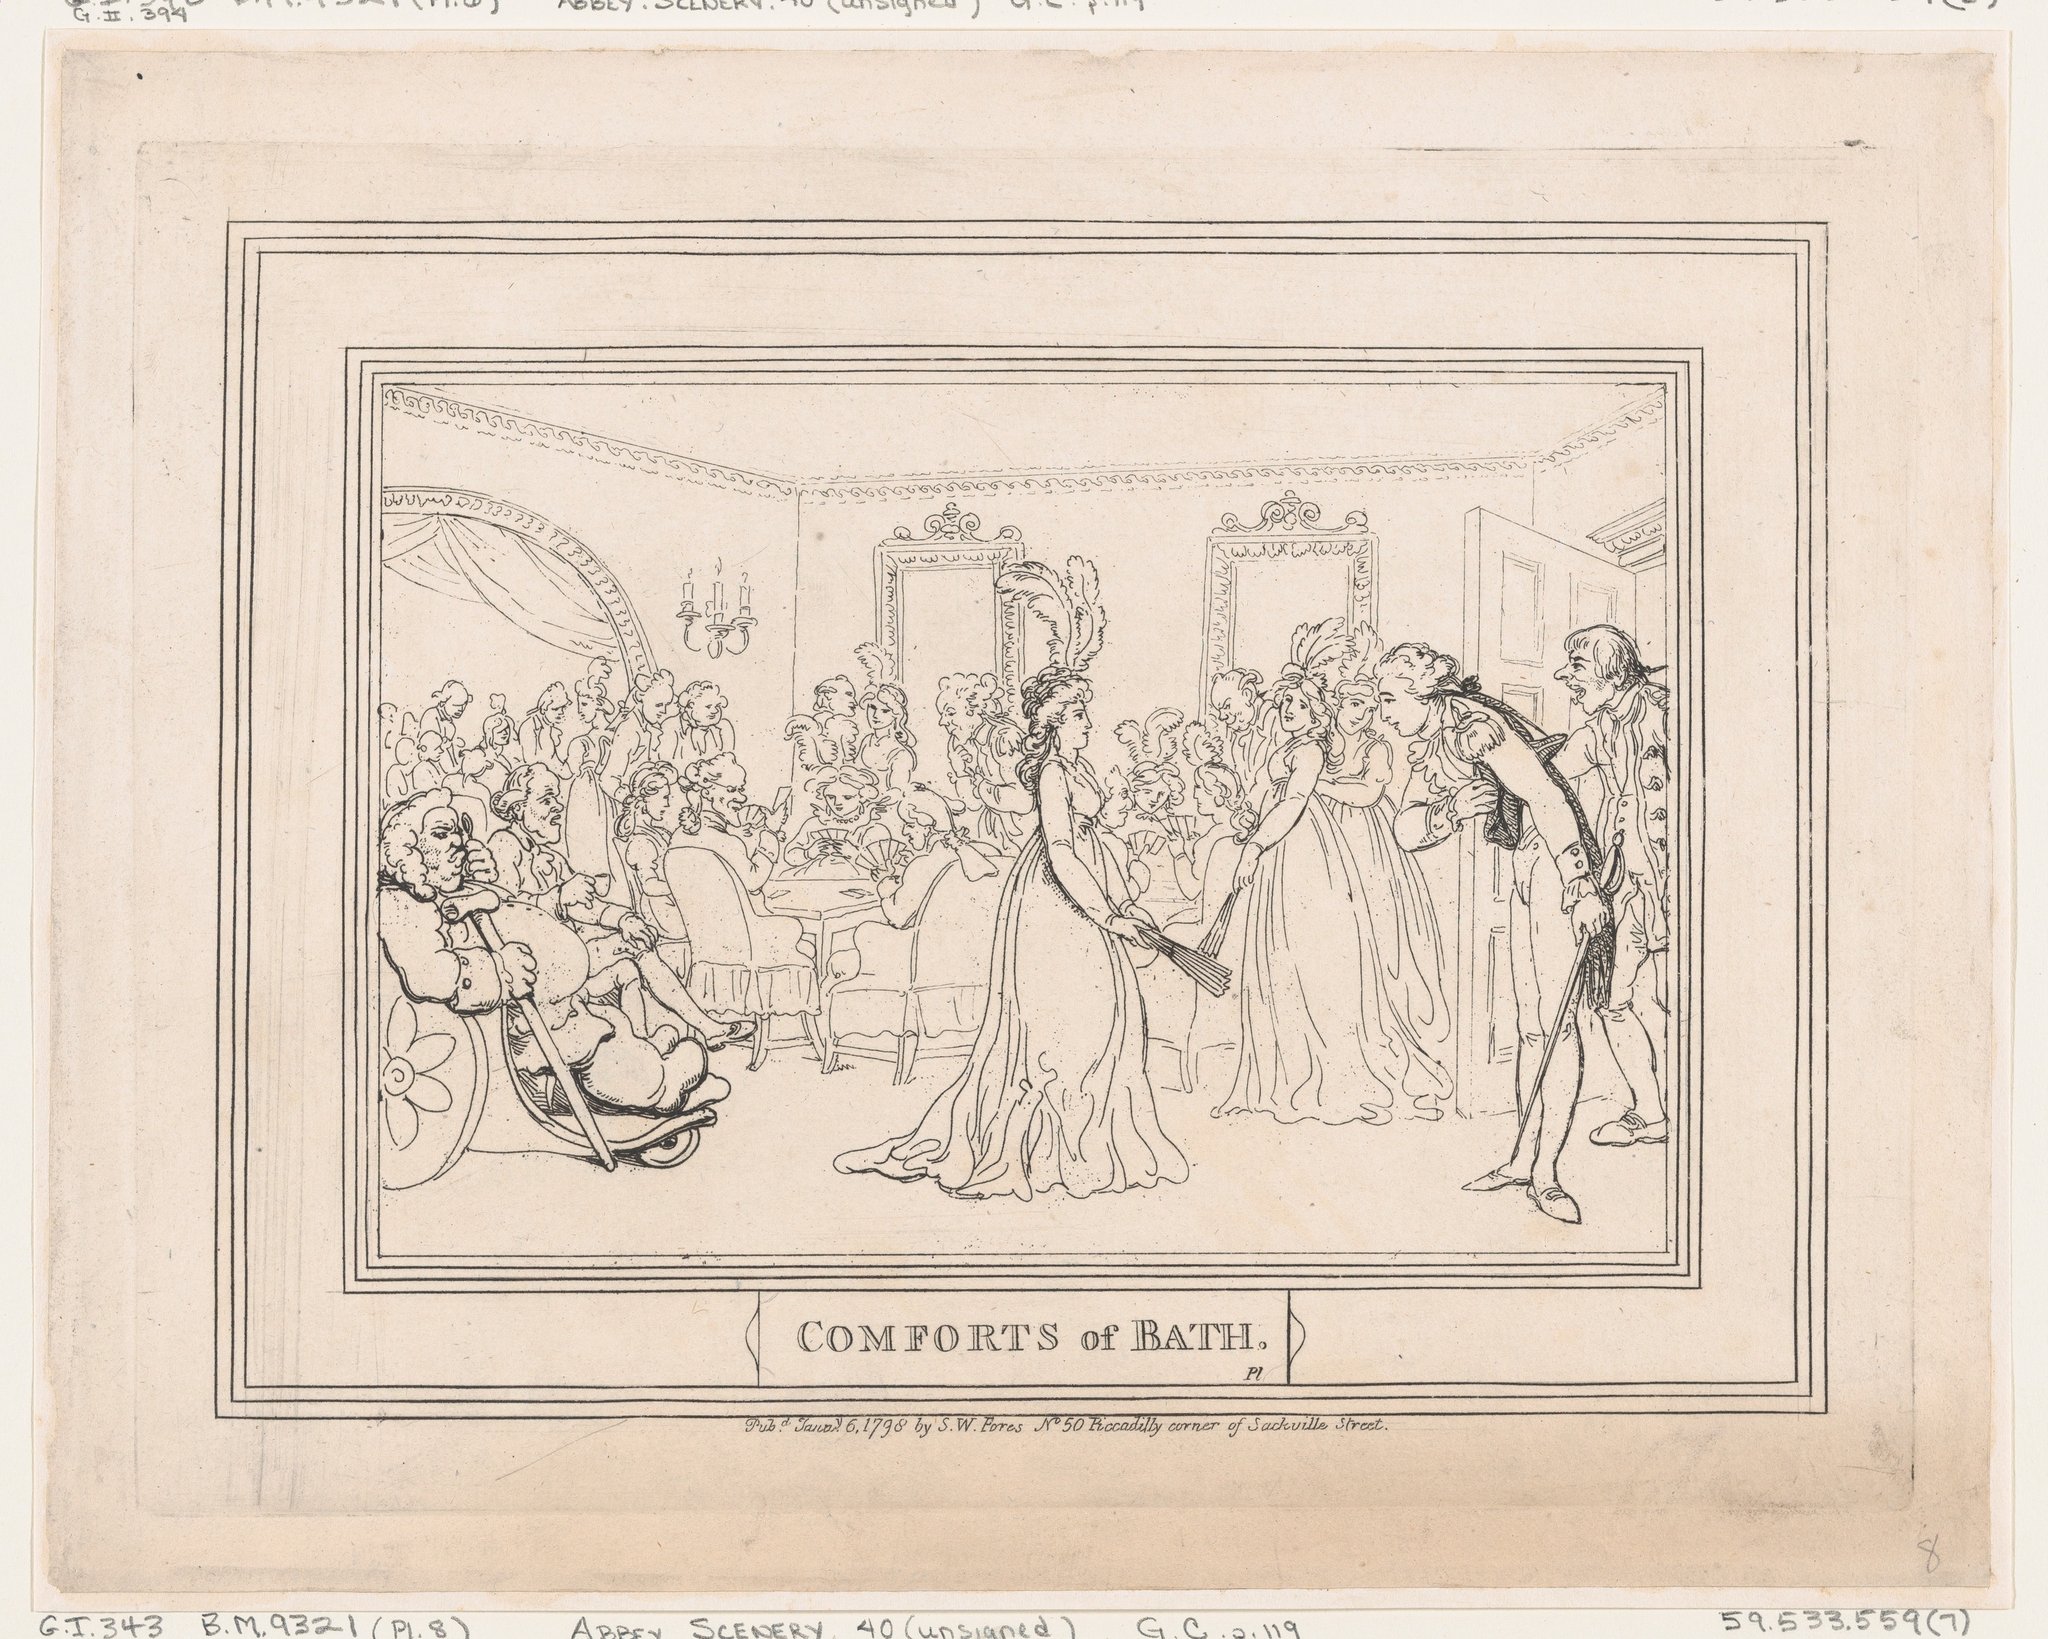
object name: print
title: Comforts of Bath, Plate 8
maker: thomas rowlandson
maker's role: artist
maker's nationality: british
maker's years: 1757-1827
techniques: etching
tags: men,women